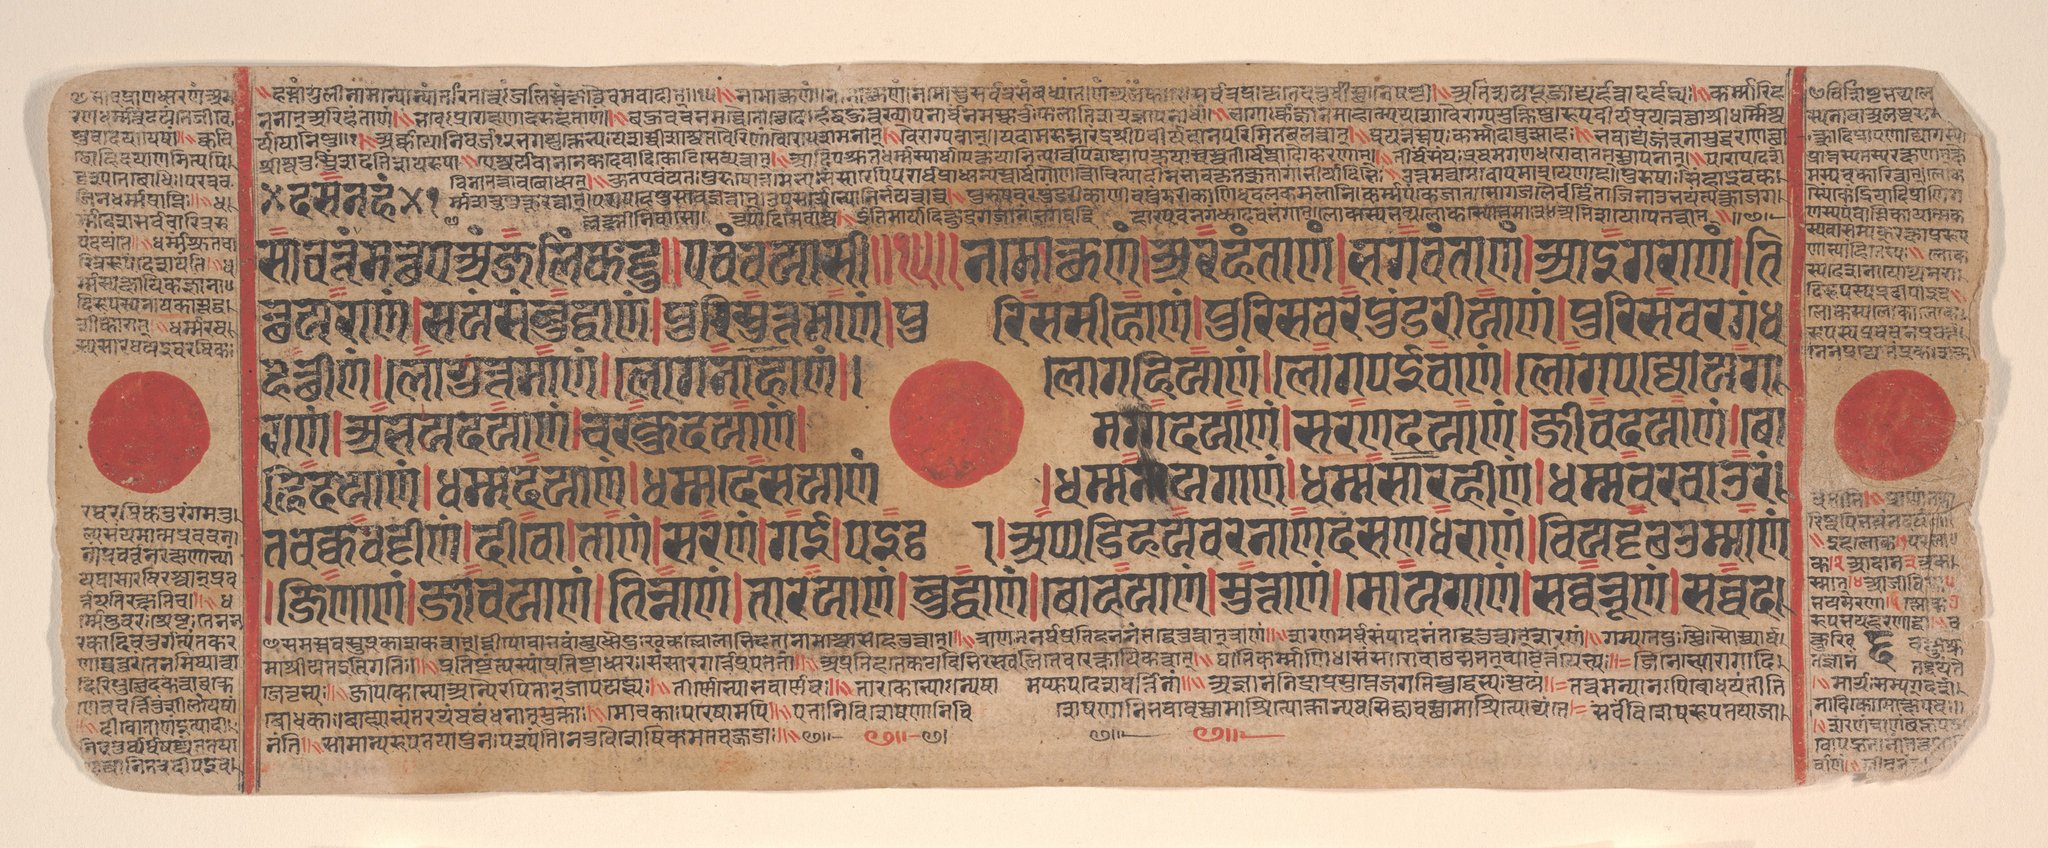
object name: folio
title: Leaf from a Kalpa Sutra (Jain Book of Rituals)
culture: indian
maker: bhadrabahu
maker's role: artist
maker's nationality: indian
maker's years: 356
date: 1401-1500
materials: gold, ink, paper, watercolor